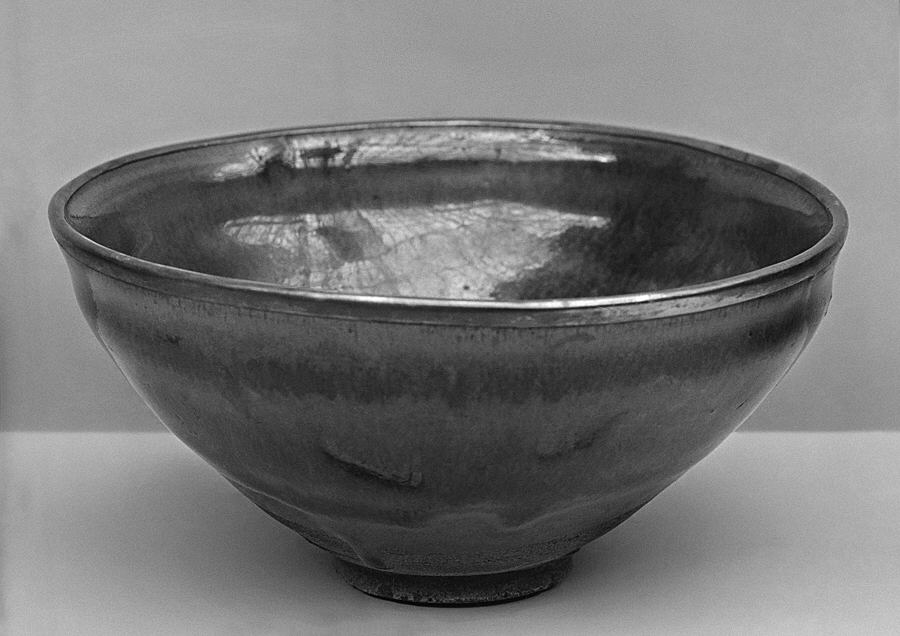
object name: bowl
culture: chinese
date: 960-1279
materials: glaze, silver